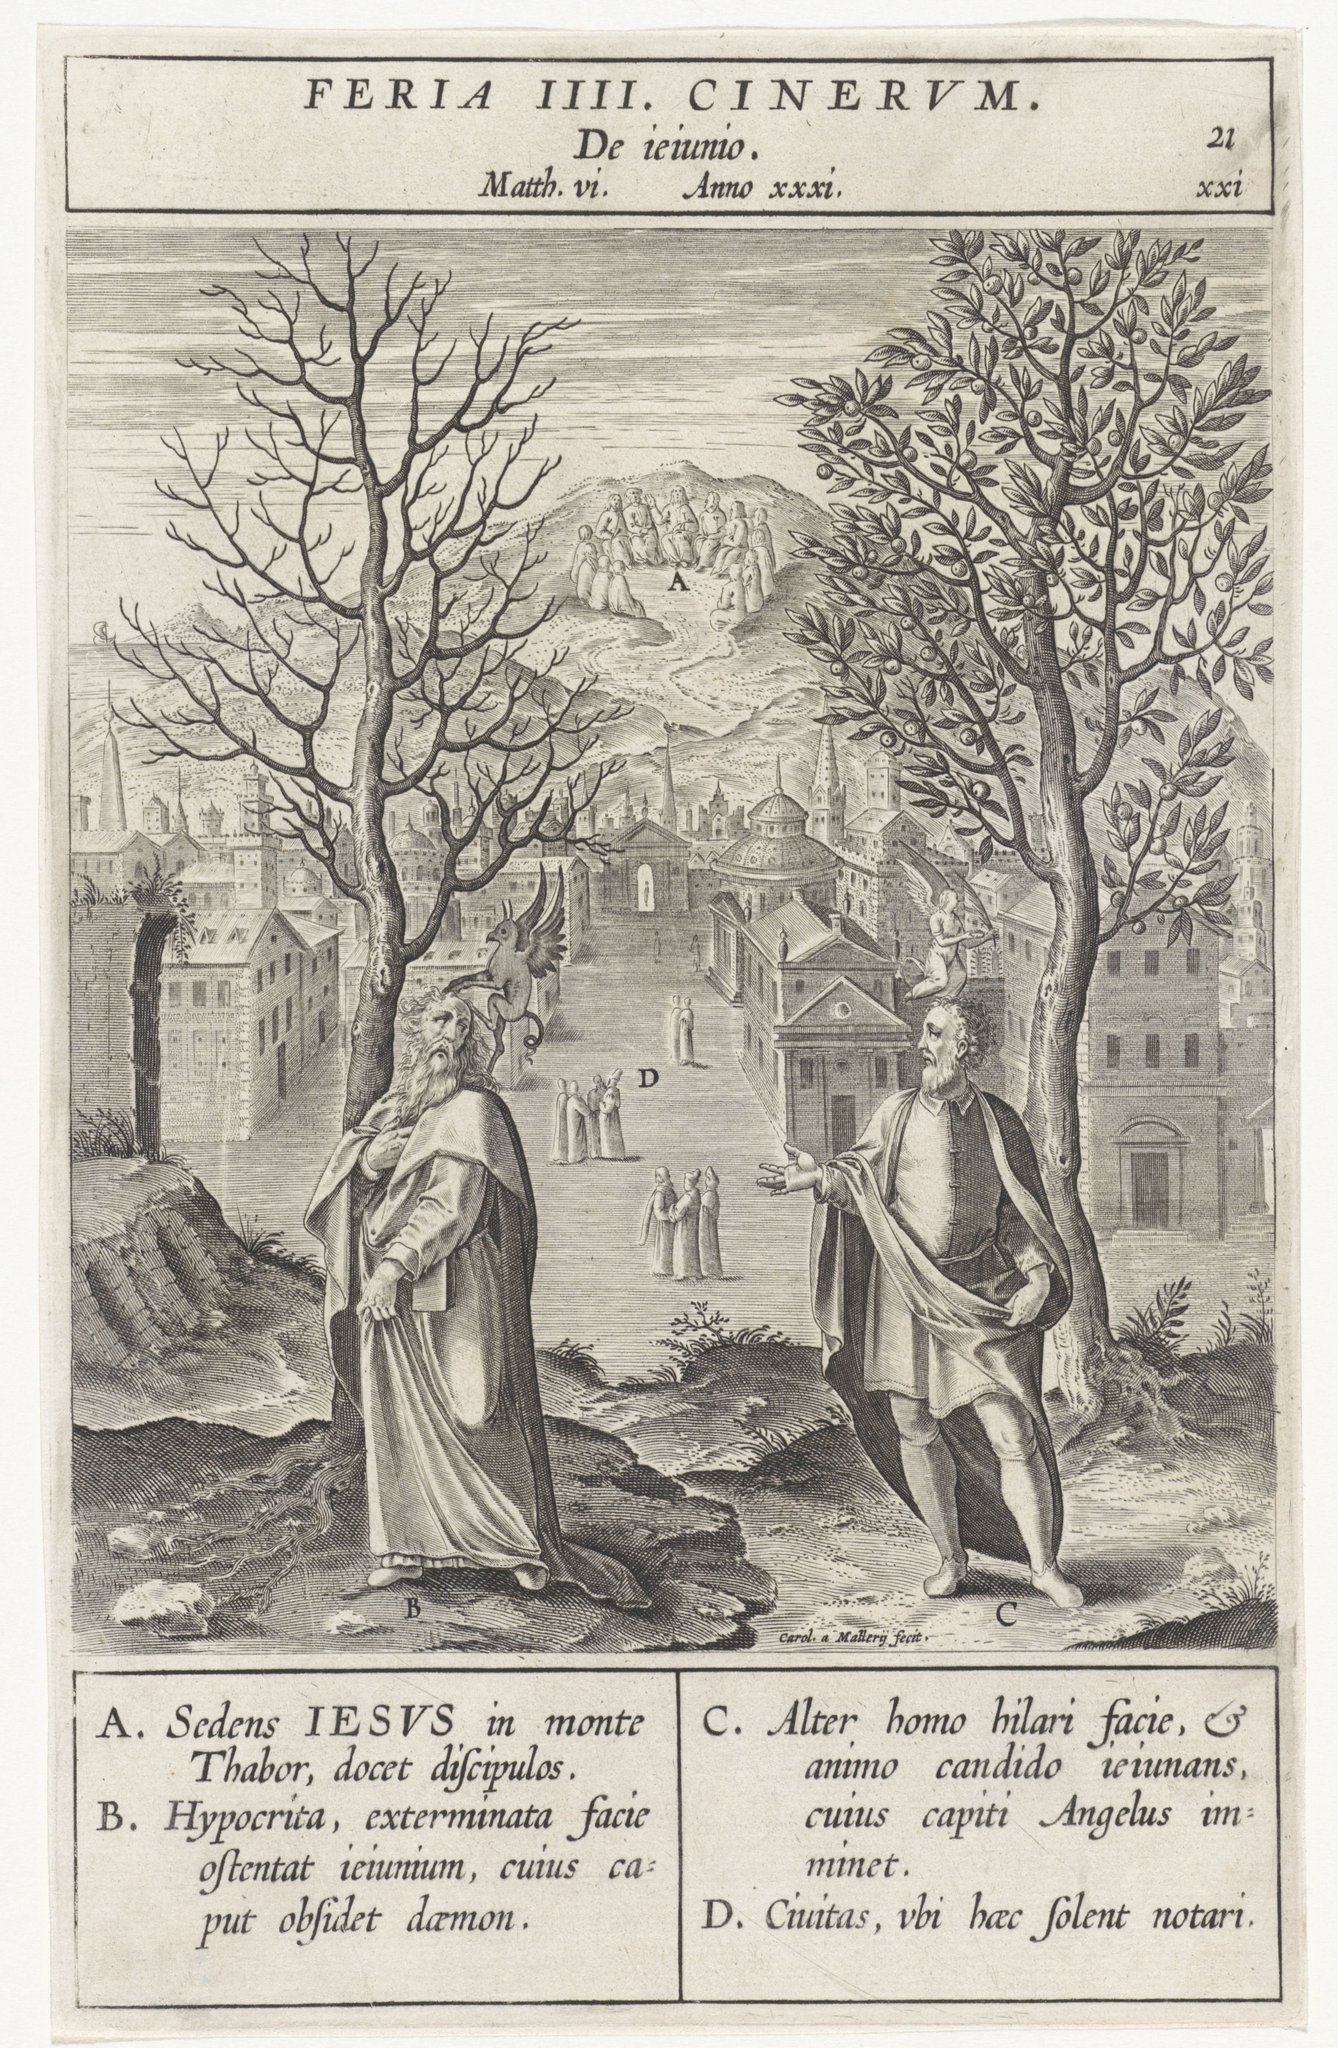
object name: print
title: Feria IIII. Cinervm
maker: karel van mallery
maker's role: print maker, publisher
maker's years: 1571-1635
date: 1593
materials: paper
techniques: engraving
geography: antwerp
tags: 'when you fast, ... your fasting may not be seen by men' (matthew 6:16-18), christ's sermon on the mount (matthew 5-7)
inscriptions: collector's mark: Lugt 2165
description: De huichelaar, met een duivel boven het hoofd, laat zien dat hij aan het vasten is. De gelovige, met een engel boven het hoofd, heeft zijn gezicht ingewreven met olie waardoor niemand merkt dat hij aan het vasten is. Ze staan voor een dorre en een bloeiende boom, vermoedelijk een verwijzing naar Mat. 7:17: "Zo draagt elke goede boom goede vruchten, maar een slechte boom draagt slechte vruchten." Bij verschillende elementen uit de voorstelling staan letters die corresponderen met de legenda in de marge.